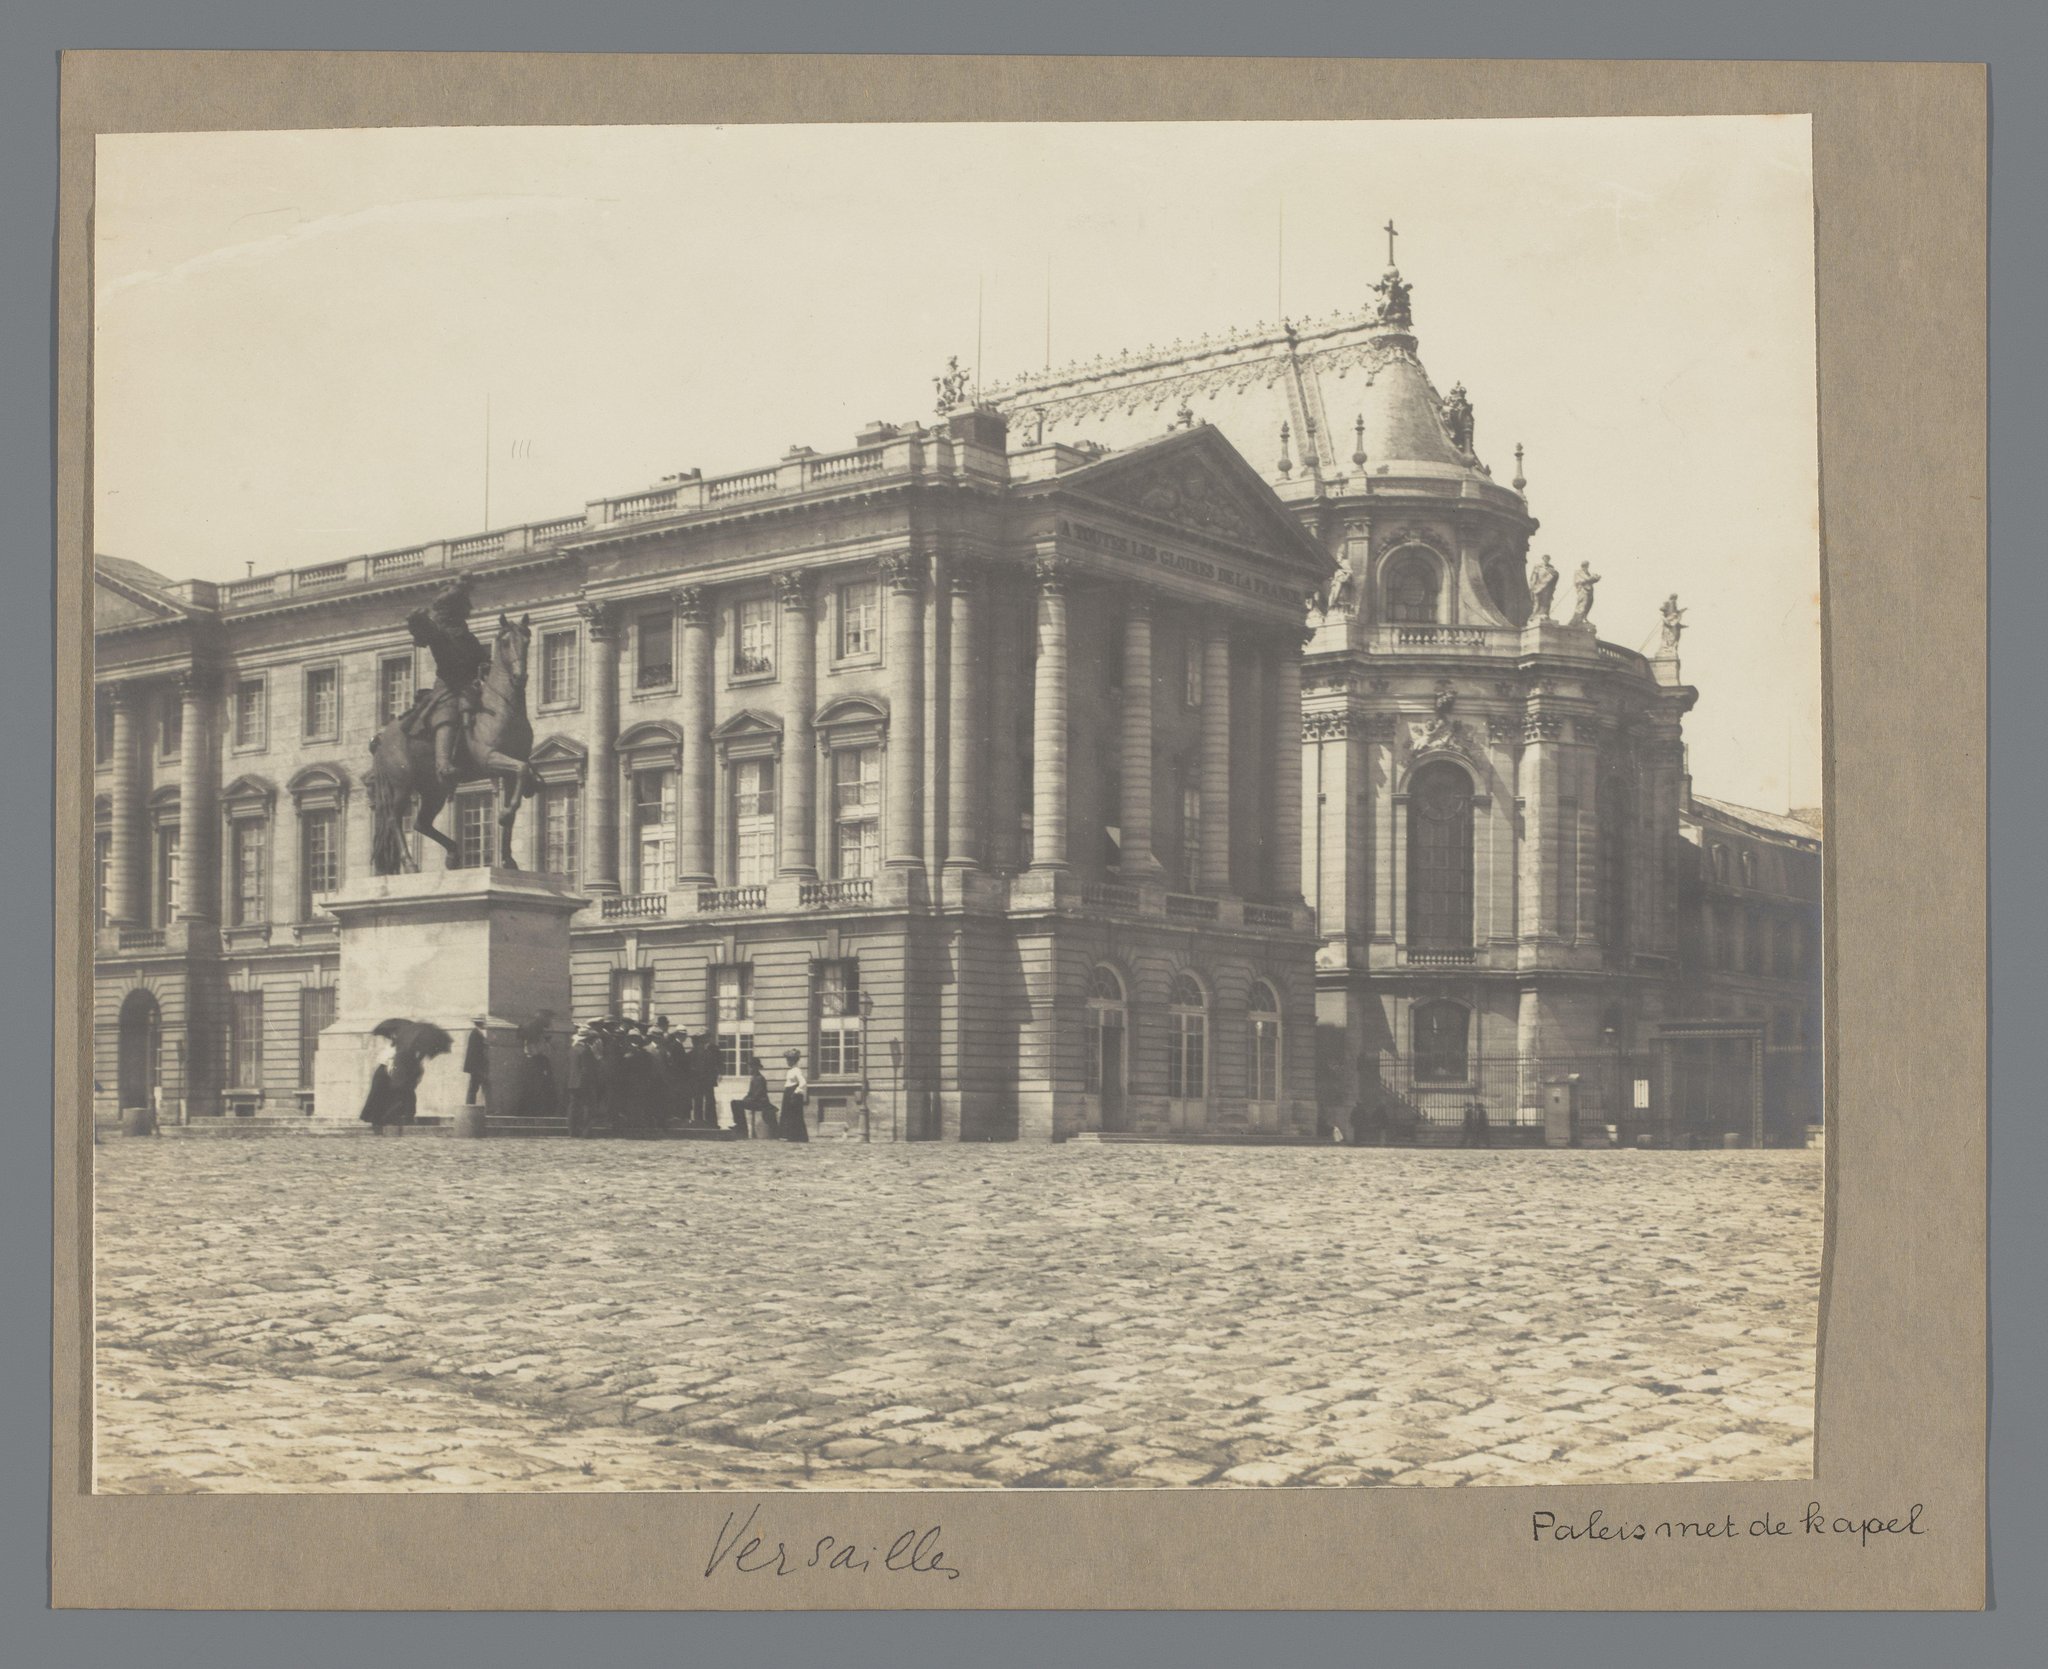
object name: photograph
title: Versailles. Palais der Koningen van Frankrijk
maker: Anonymous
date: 1880-1930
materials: photographic support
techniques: gelatin silver print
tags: kasteel van versailles